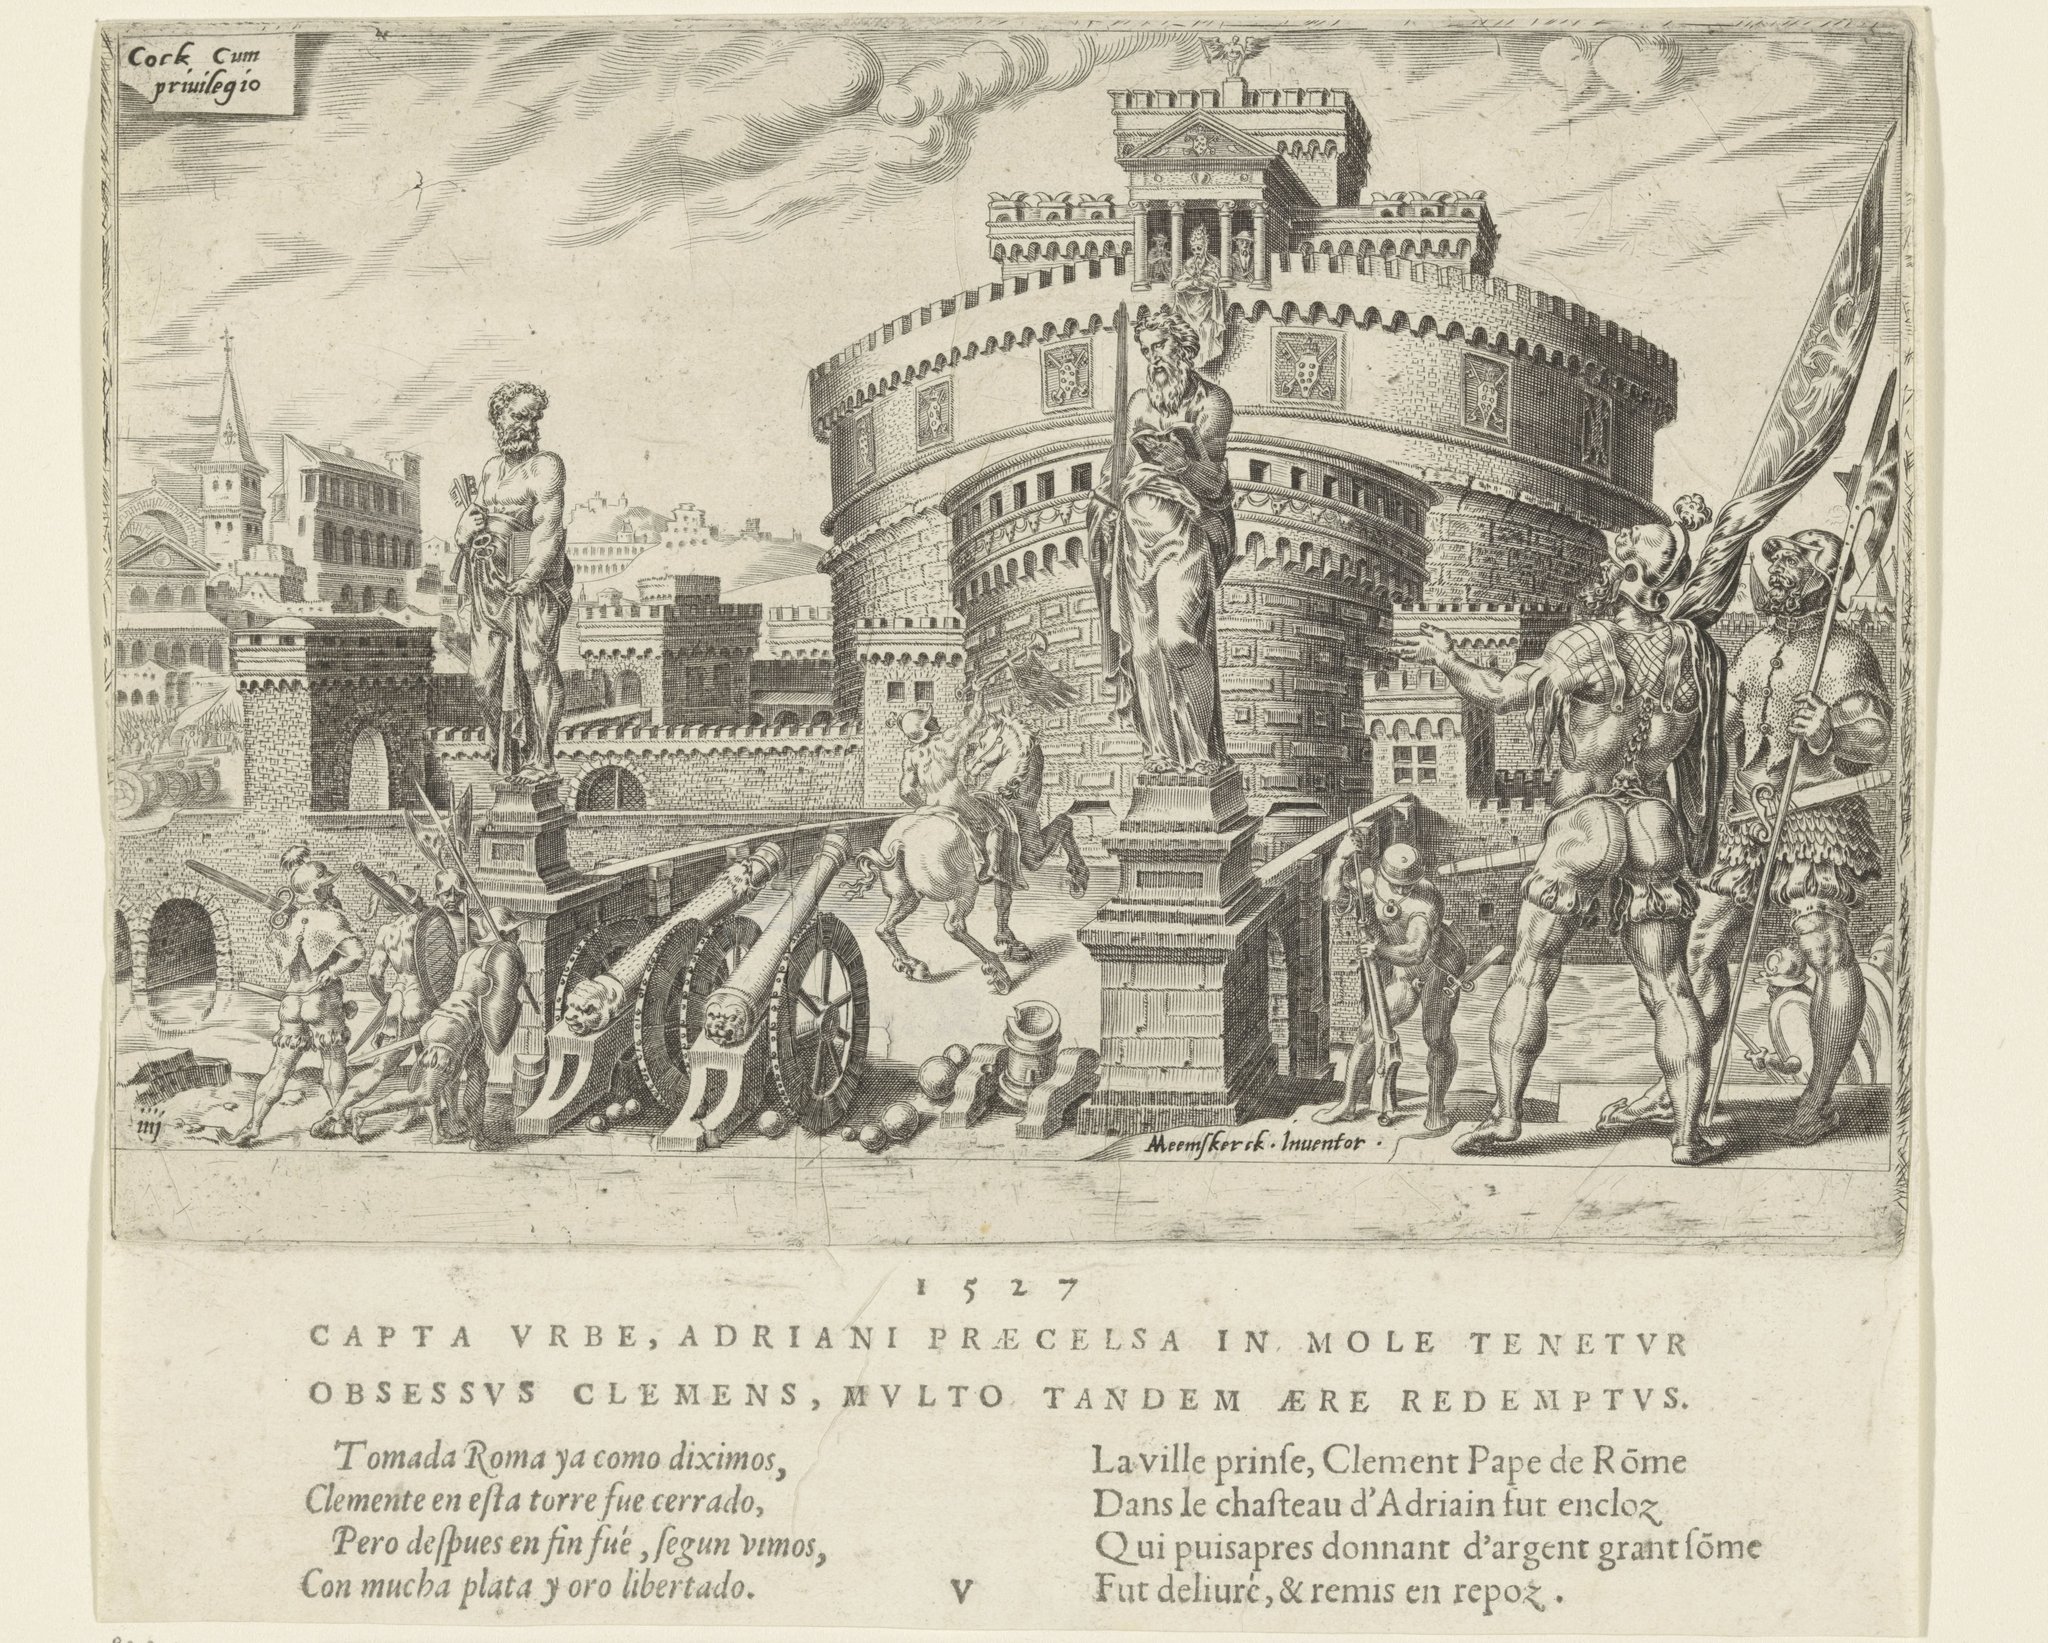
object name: history print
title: Belegering van de Engelenburcht, 1527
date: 1555-1556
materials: paper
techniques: engraving, etching, letterpress printing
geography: haarlem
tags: ghent, charles v (holy roman emperor and king of spain), firearms: cannon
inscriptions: collector's mark: Lugt 2760, collector's mark: Lugt 2228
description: De belegering van de Engelenburcht in Rome (1527). Clemens VII kijkt vanuit de Engelenburcht naar de bezettingsmacht van Rome. Twee kanonnen op de voorgrond. Op de achtergrond de Tiber en de Engelenburcht. De prent heeft een Latijns, Spaans en Frans onderschrift en maakt deel uit van een twaalfdelige serie over de overwinningen van Karel V.